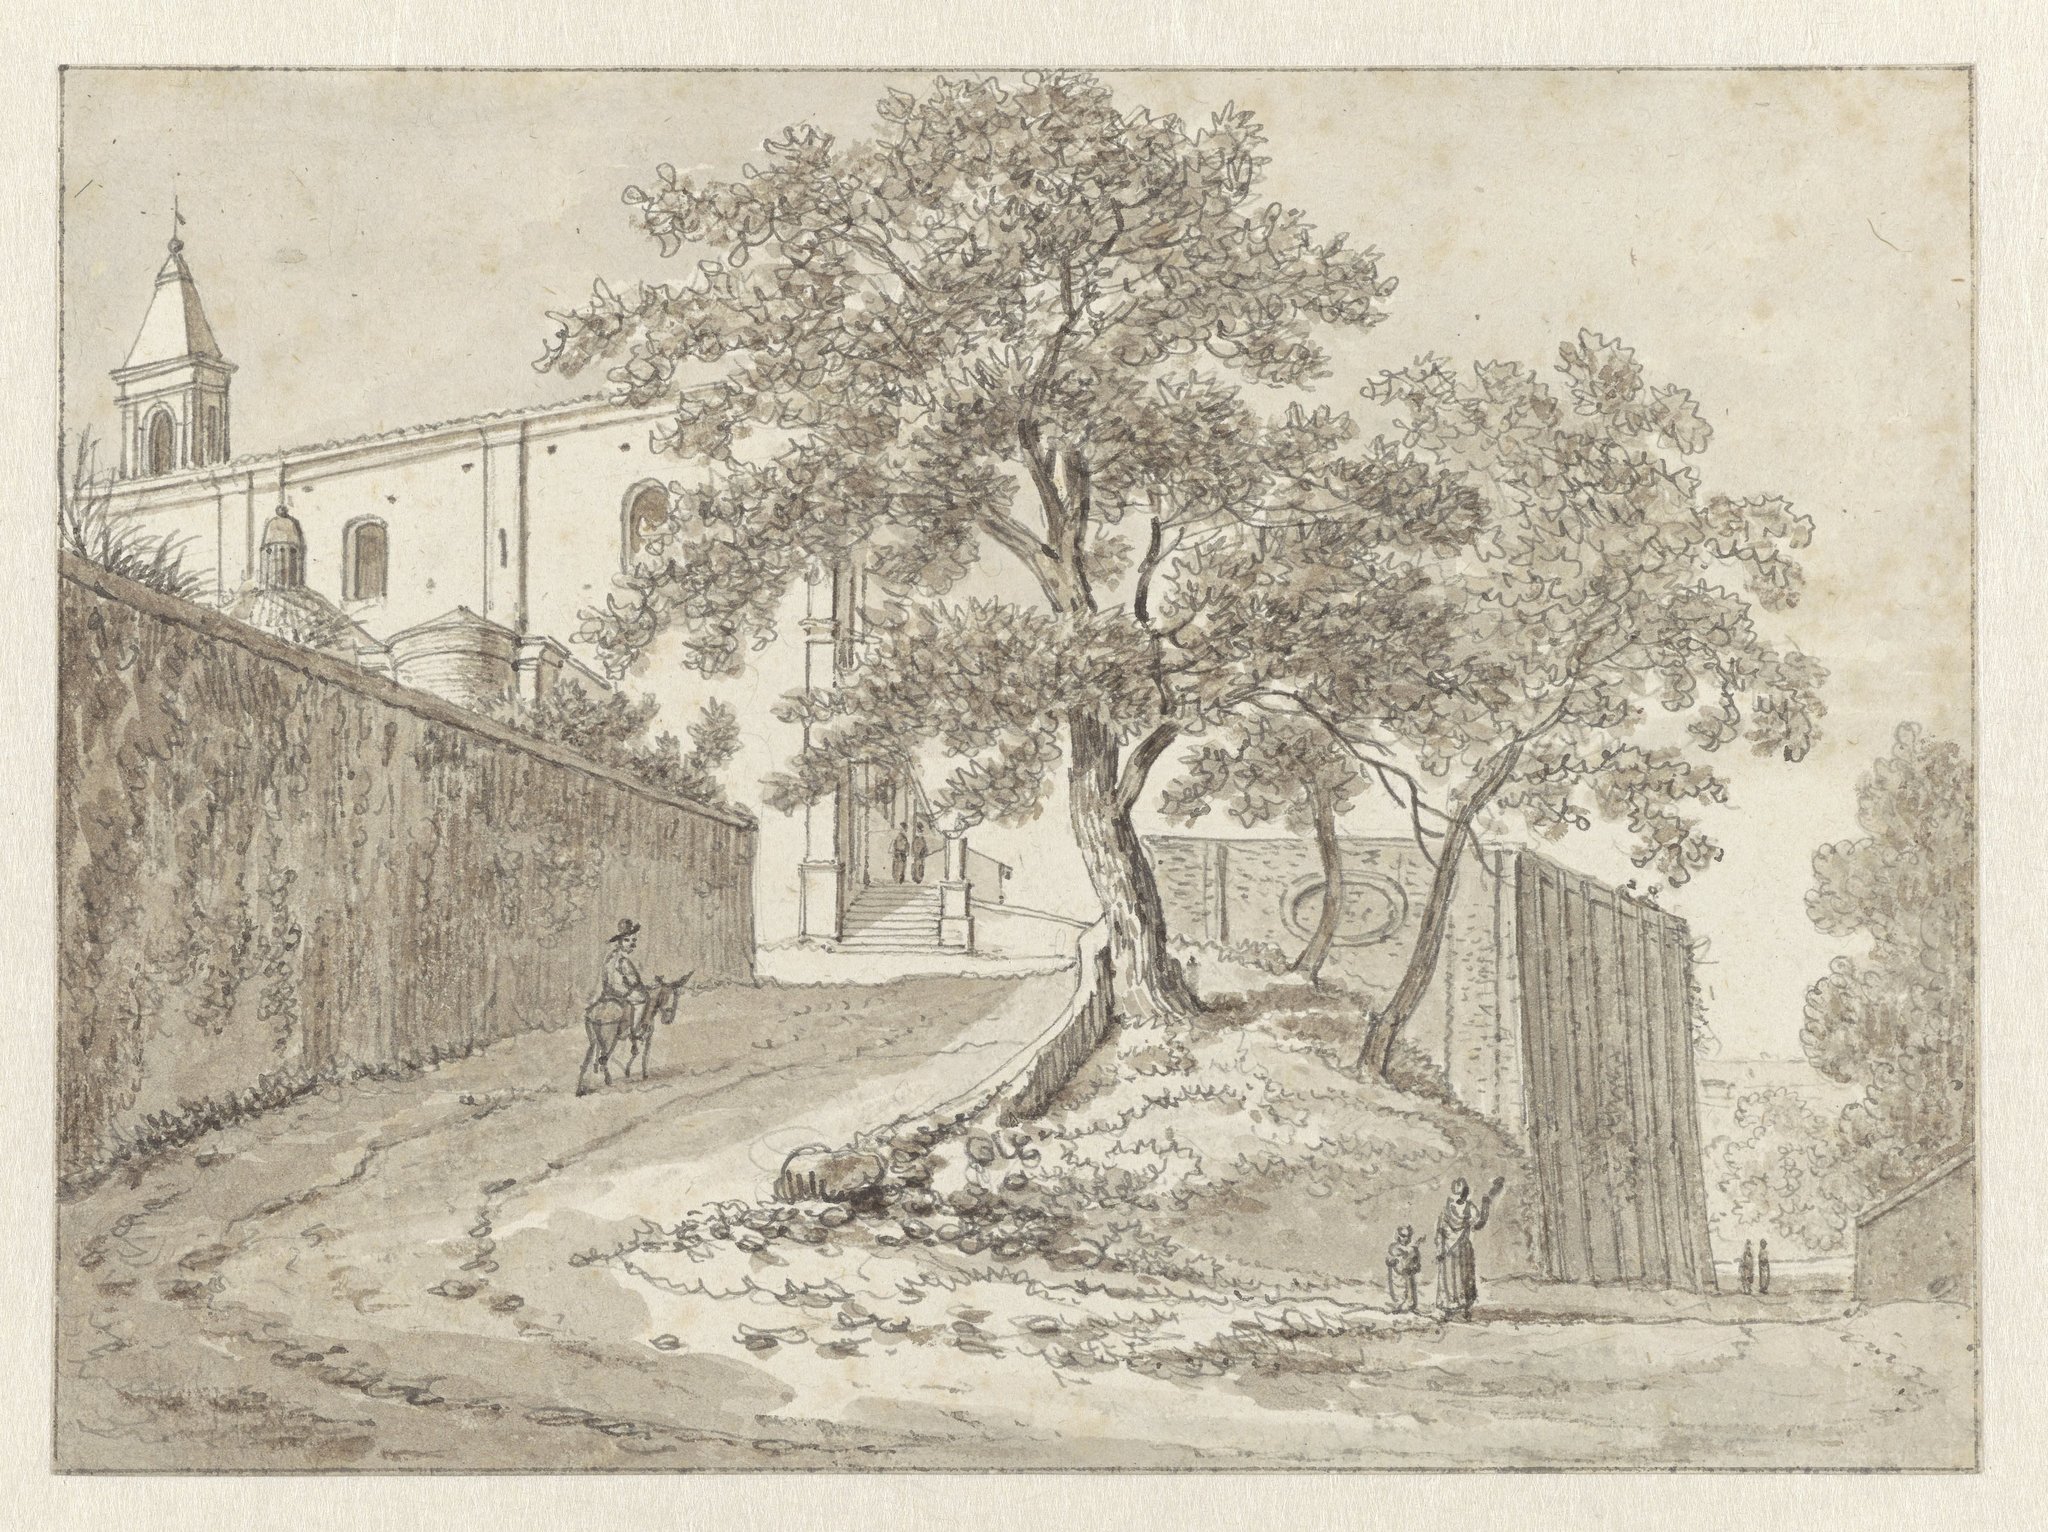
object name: drawing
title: Een man op een ezel voor San Pietro in Montorio, Rome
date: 1761-1817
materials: chalk, ink, paper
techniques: brush, pen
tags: church (exterior), public road, rome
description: Tekening uit een groep tekeningen van landschappen en stadsgezichten in Italië (Rome, Tivoli, Civita Castellana en Pozzuoli).